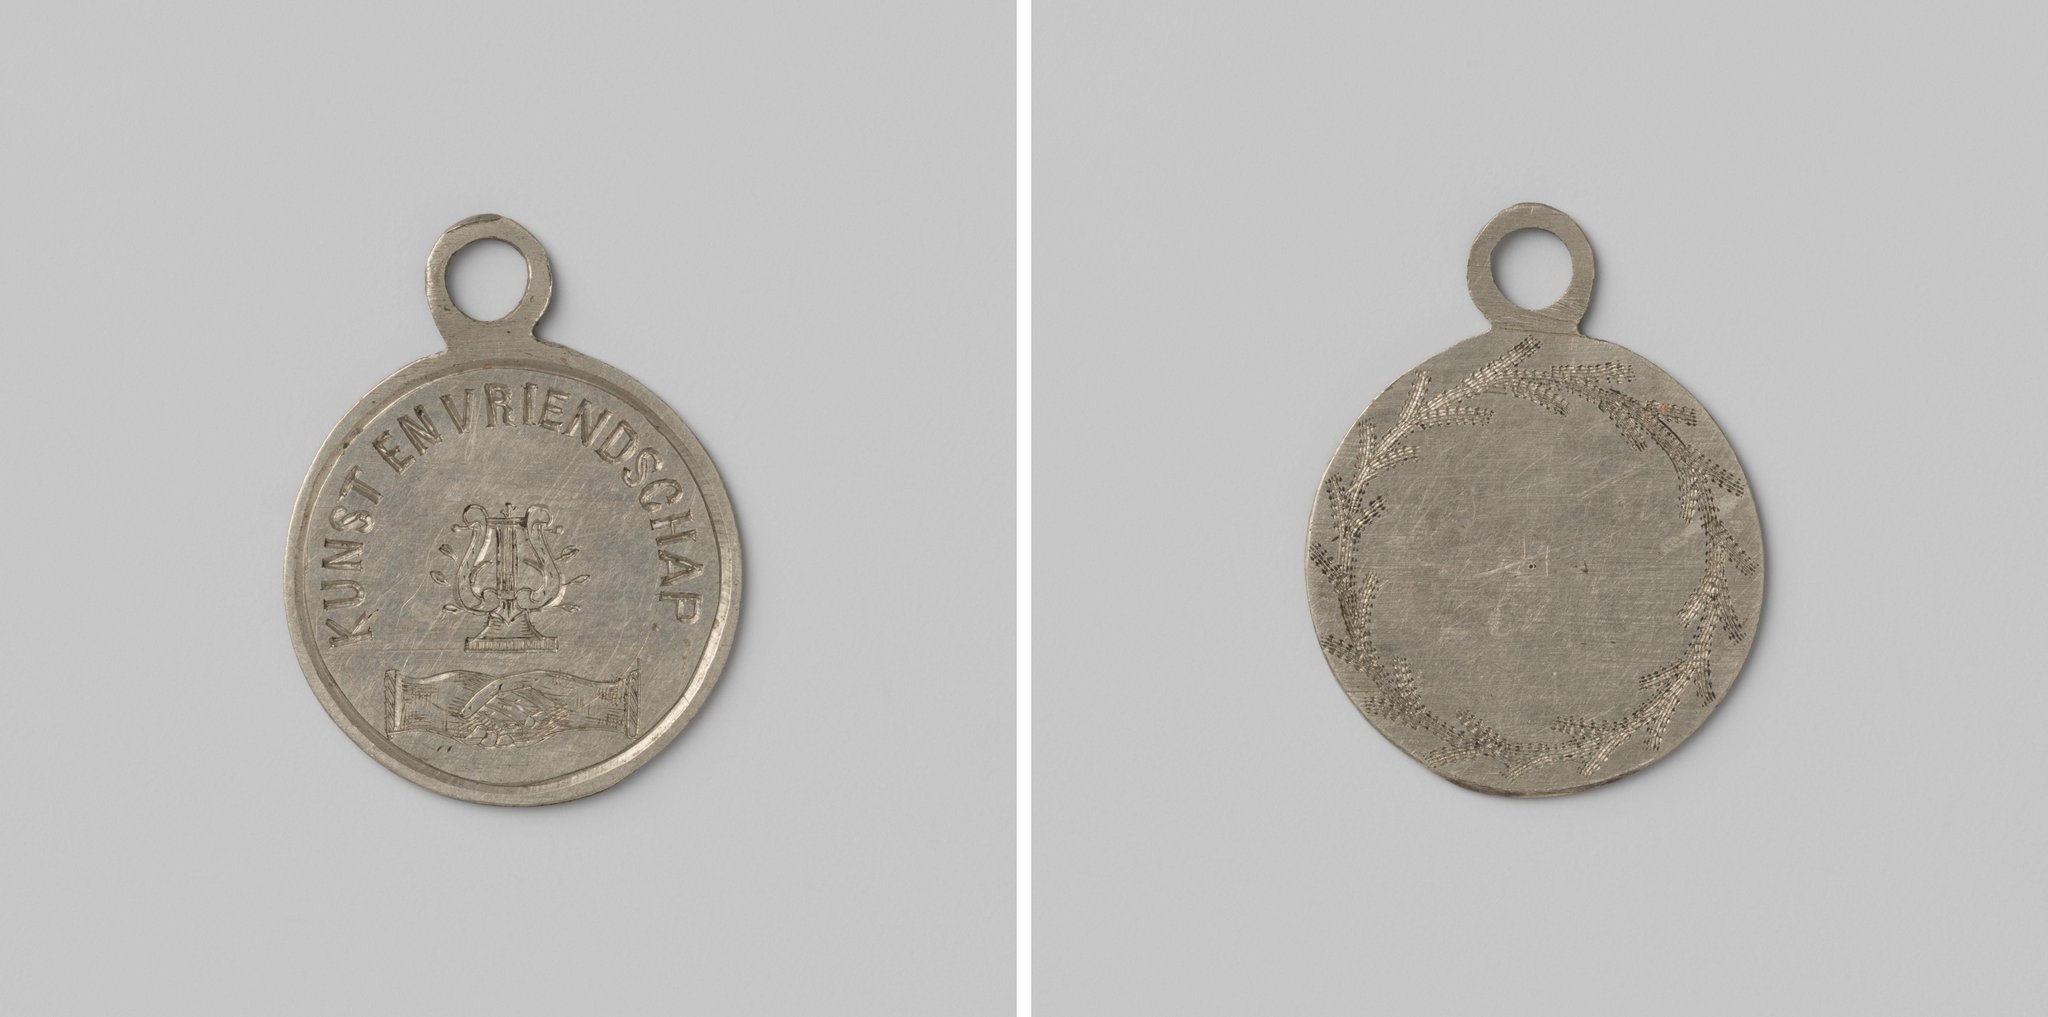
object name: medal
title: Muziekvereniging Kunst en Vriendschap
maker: Anonymous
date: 1825-1875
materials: cardboard, silver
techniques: engraving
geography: netherlands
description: Zilveren penning aan draagoog. Voorzijde: lier boven twee ineen geslagen handen binnen omschrift. Keerzijde: blanco veld binnen bladerkrans; bijbehorend rood doosje, ingelegd met donkerrood fluweel en ingeplakt nummer 1122